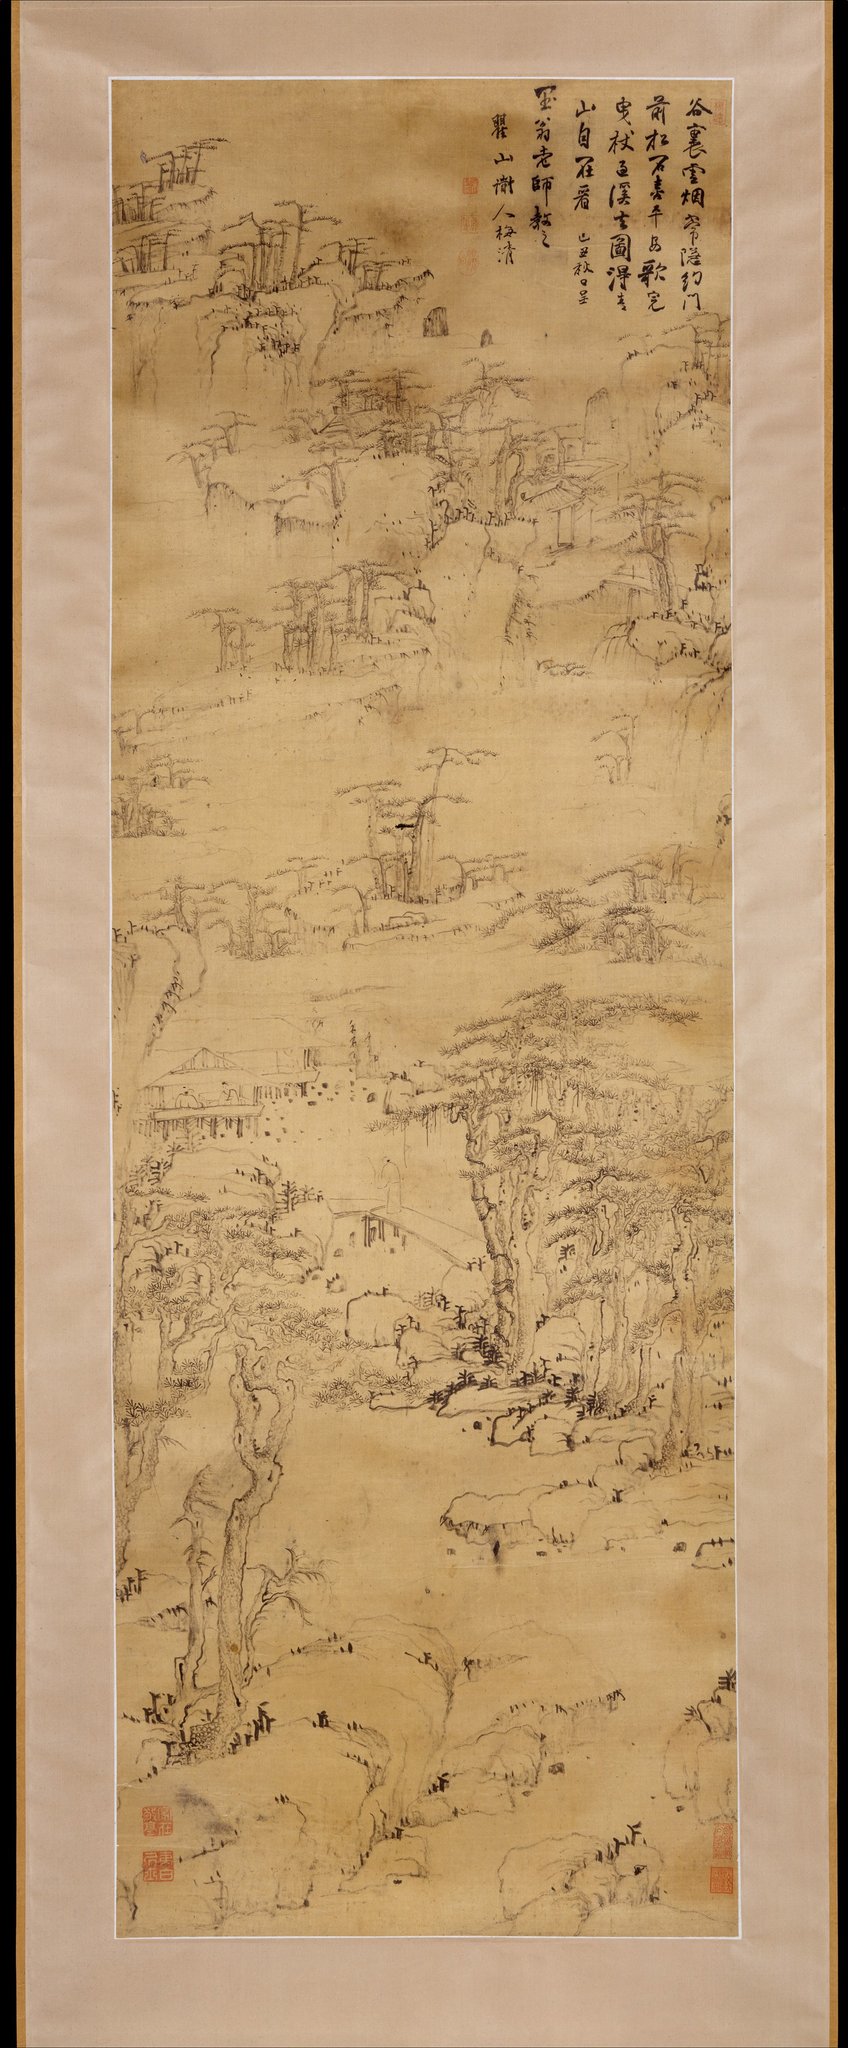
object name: hanging scroll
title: Strolling in a Misty Valley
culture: chinese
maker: mei qing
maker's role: artist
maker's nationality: chinese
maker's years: 1623-1697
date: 1649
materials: ink, textile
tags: landscapes